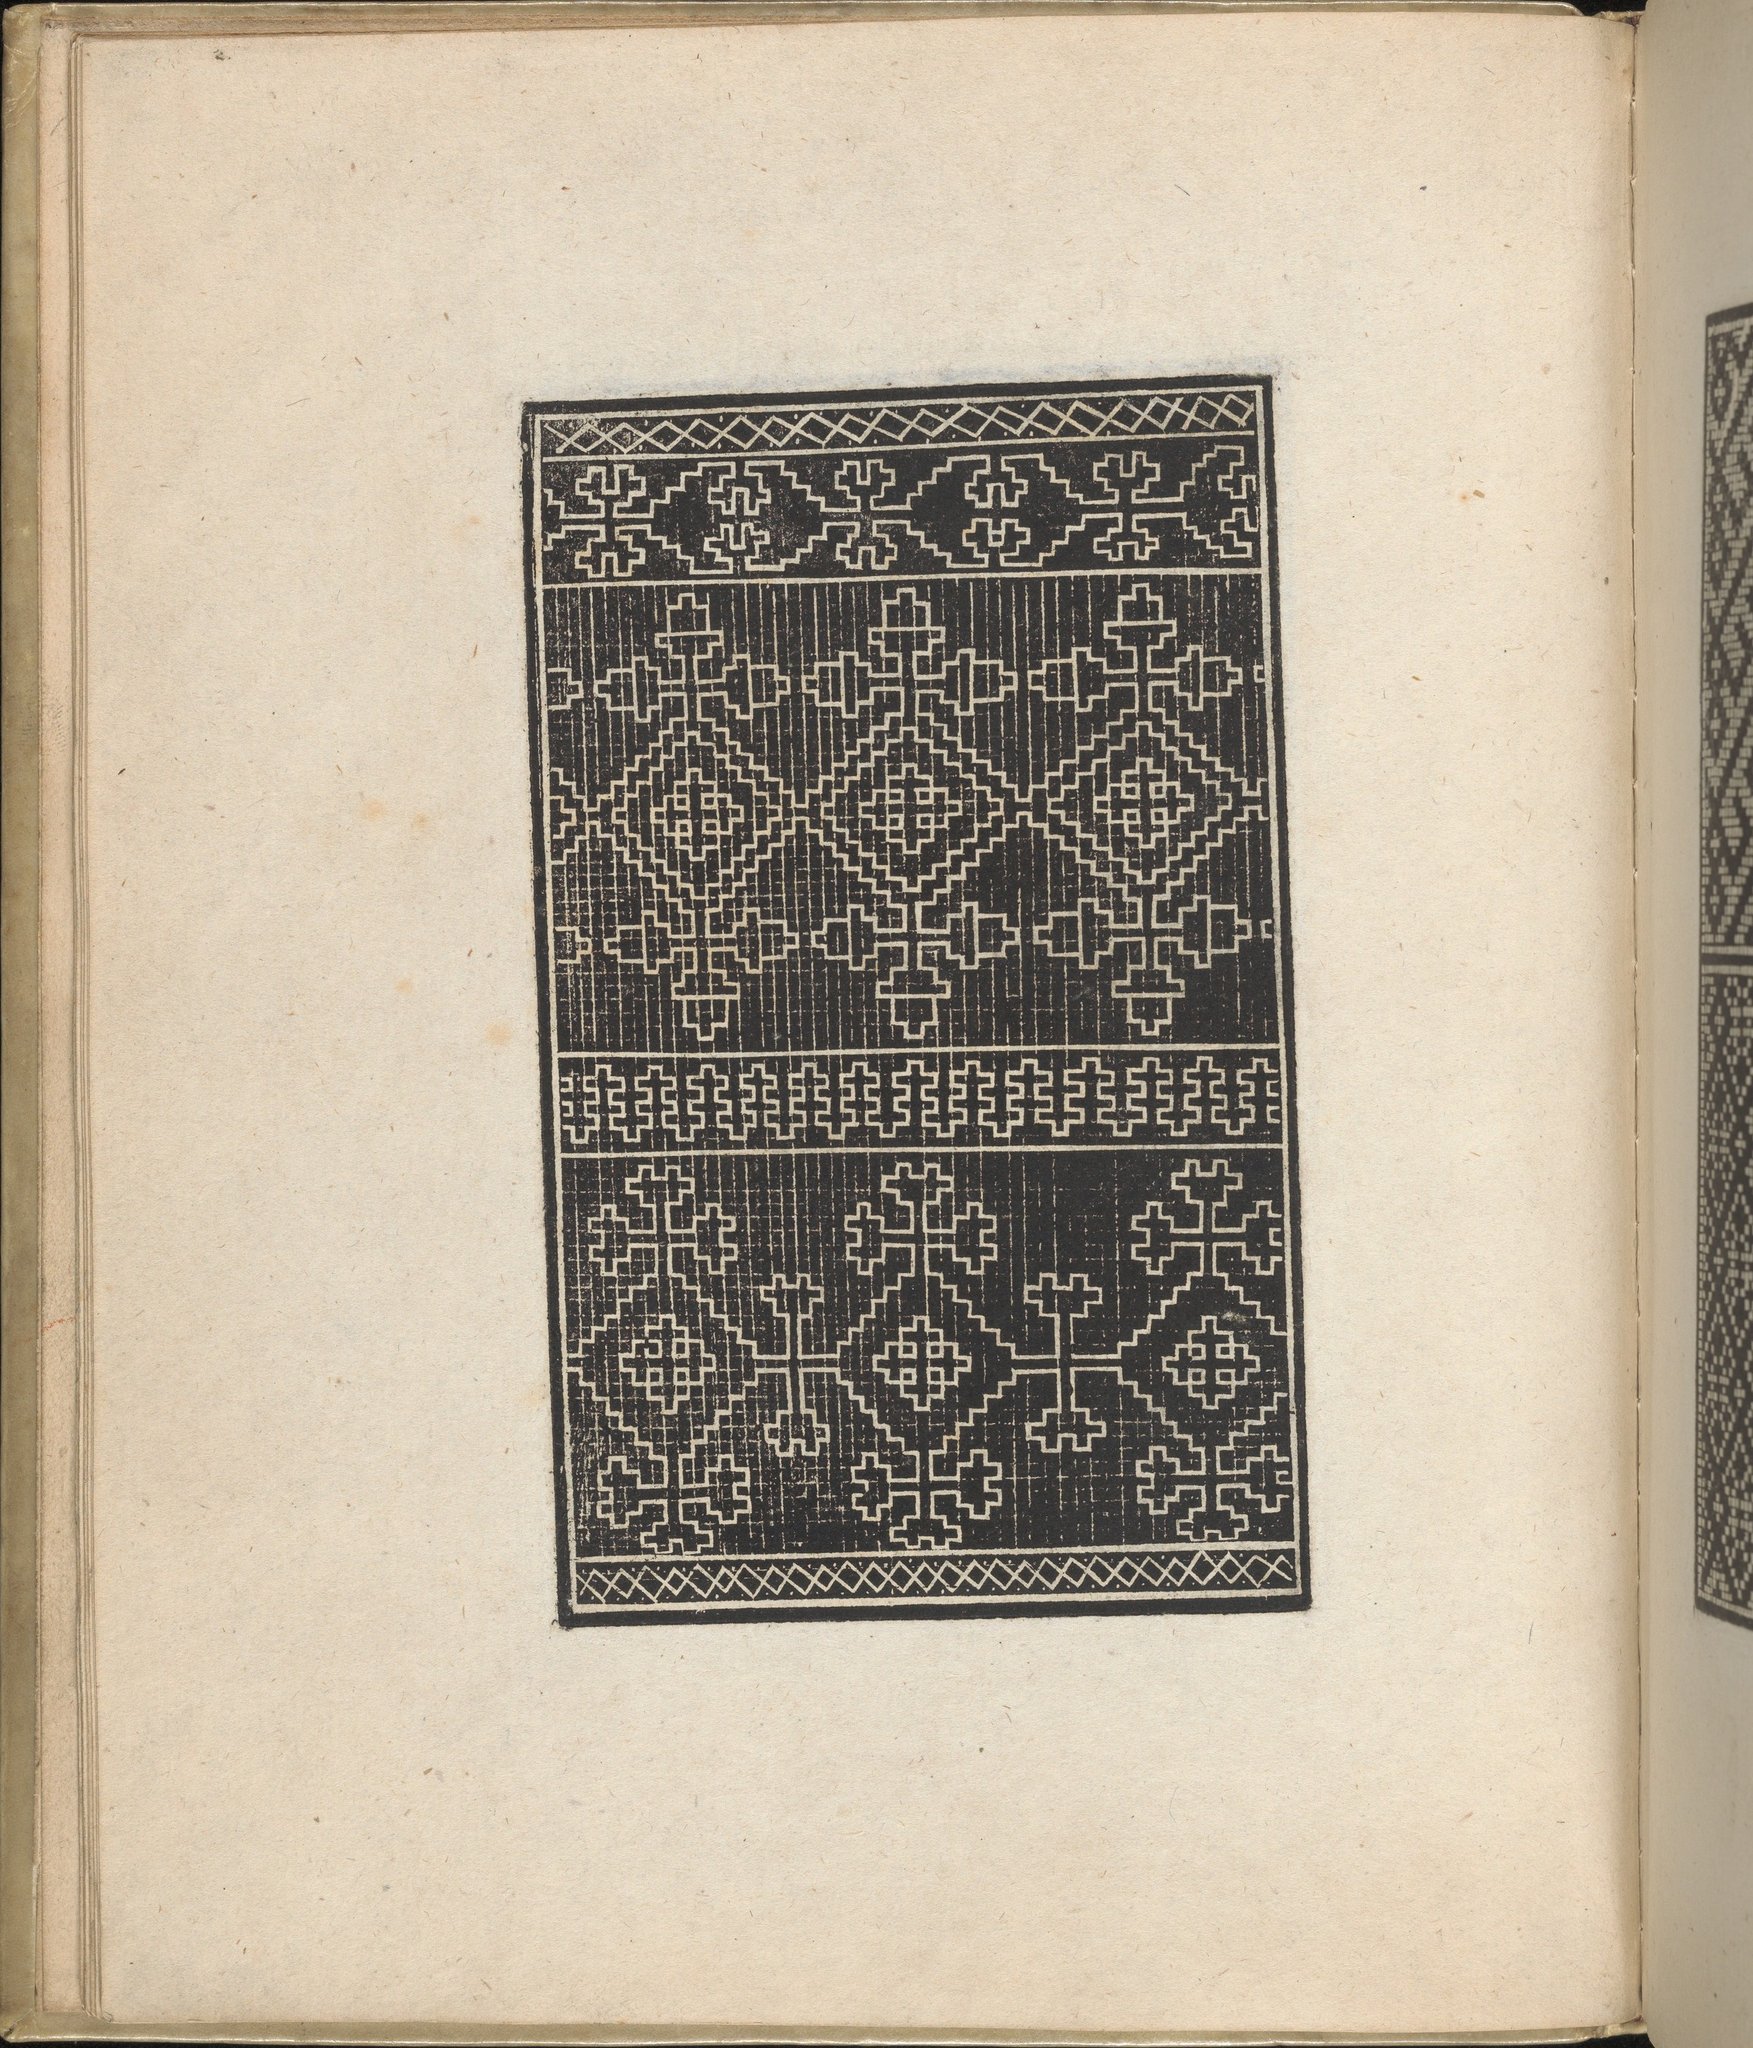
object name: book print ornament architecture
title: Trionfo Di Virtu. Libro Novo..., page 6 (verso)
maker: matteo pagano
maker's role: publisher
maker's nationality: italian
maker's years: 1515-1588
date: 1563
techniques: woodcut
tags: ornament